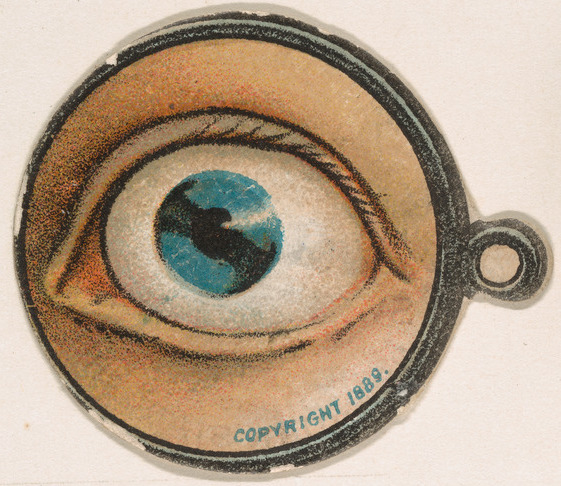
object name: print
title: Monocle and Eye (blue), from Jocular Ocular series (N221) issued by Kinney Bros.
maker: kinney brothers tobacco company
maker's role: publisher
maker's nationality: american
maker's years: 1869-2011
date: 1889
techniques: color lithograph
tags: eyes